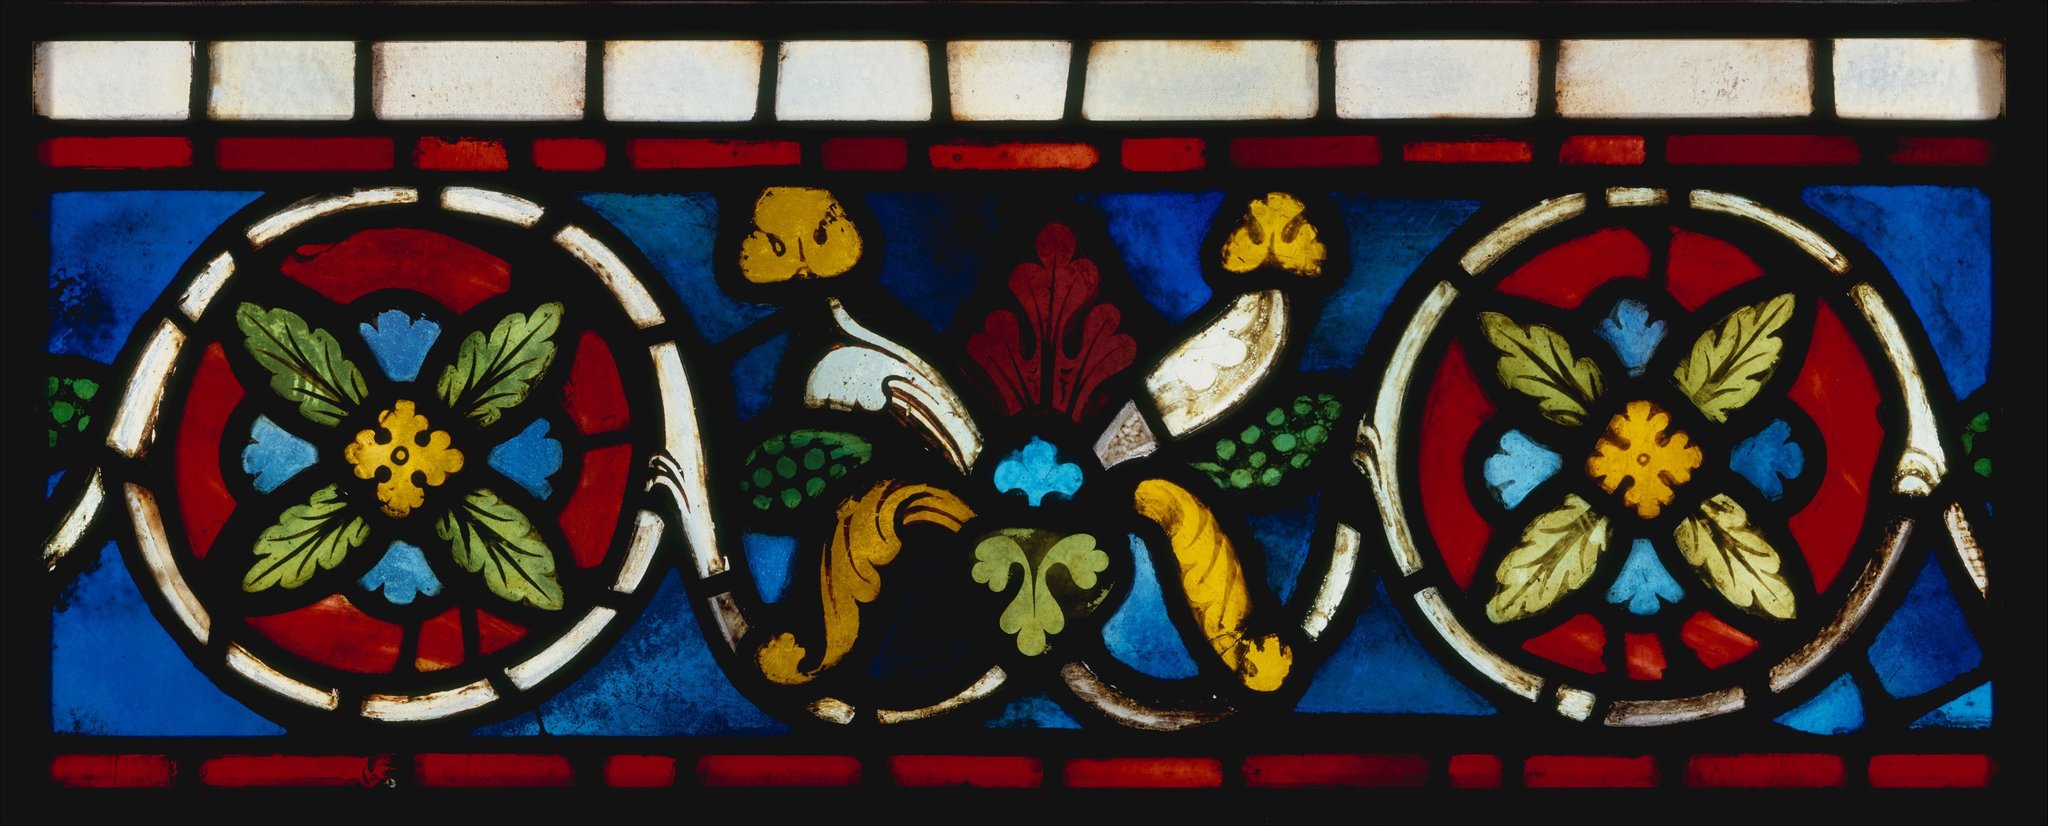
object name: border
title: Fragment of a Border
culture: french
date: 1185-1205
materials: glass, metal, paint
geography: braine or reims (?)